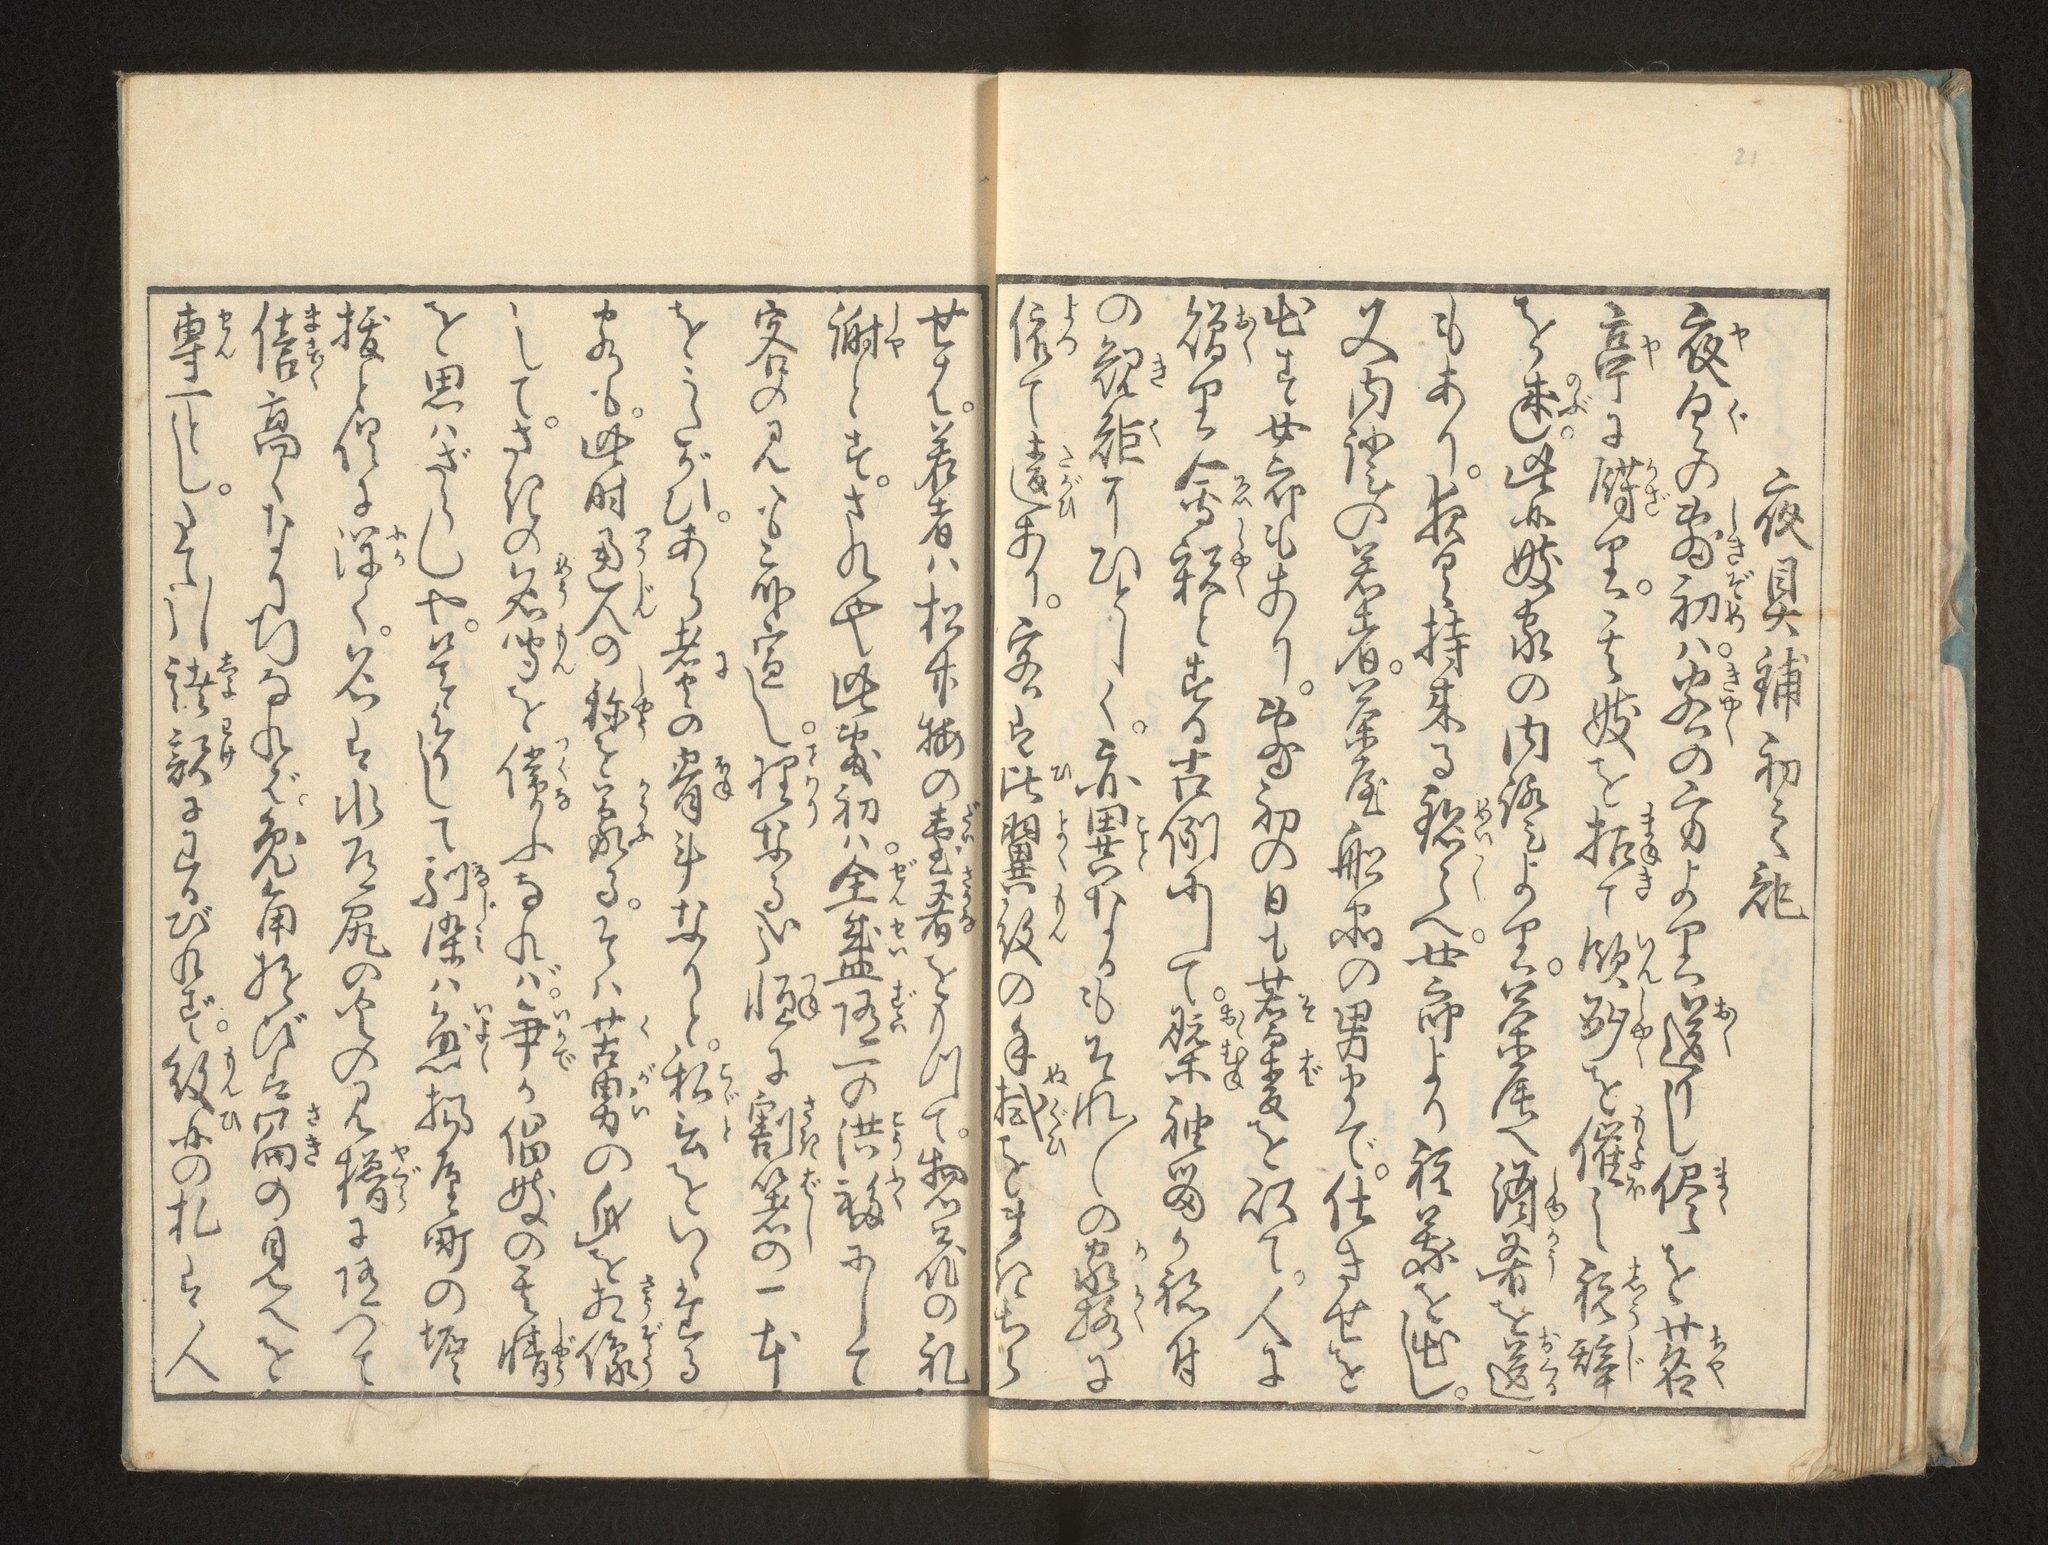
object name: page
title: Tekst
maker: jippensha ikku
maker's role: schrijver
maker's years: 1765-1831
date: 1804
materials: paper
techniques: woodcut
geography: edo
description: Pagina 40 en 41 van deel één van Utamaro`s boek: Gebeurtenissen in de lusthuizen gedurende het jaar.